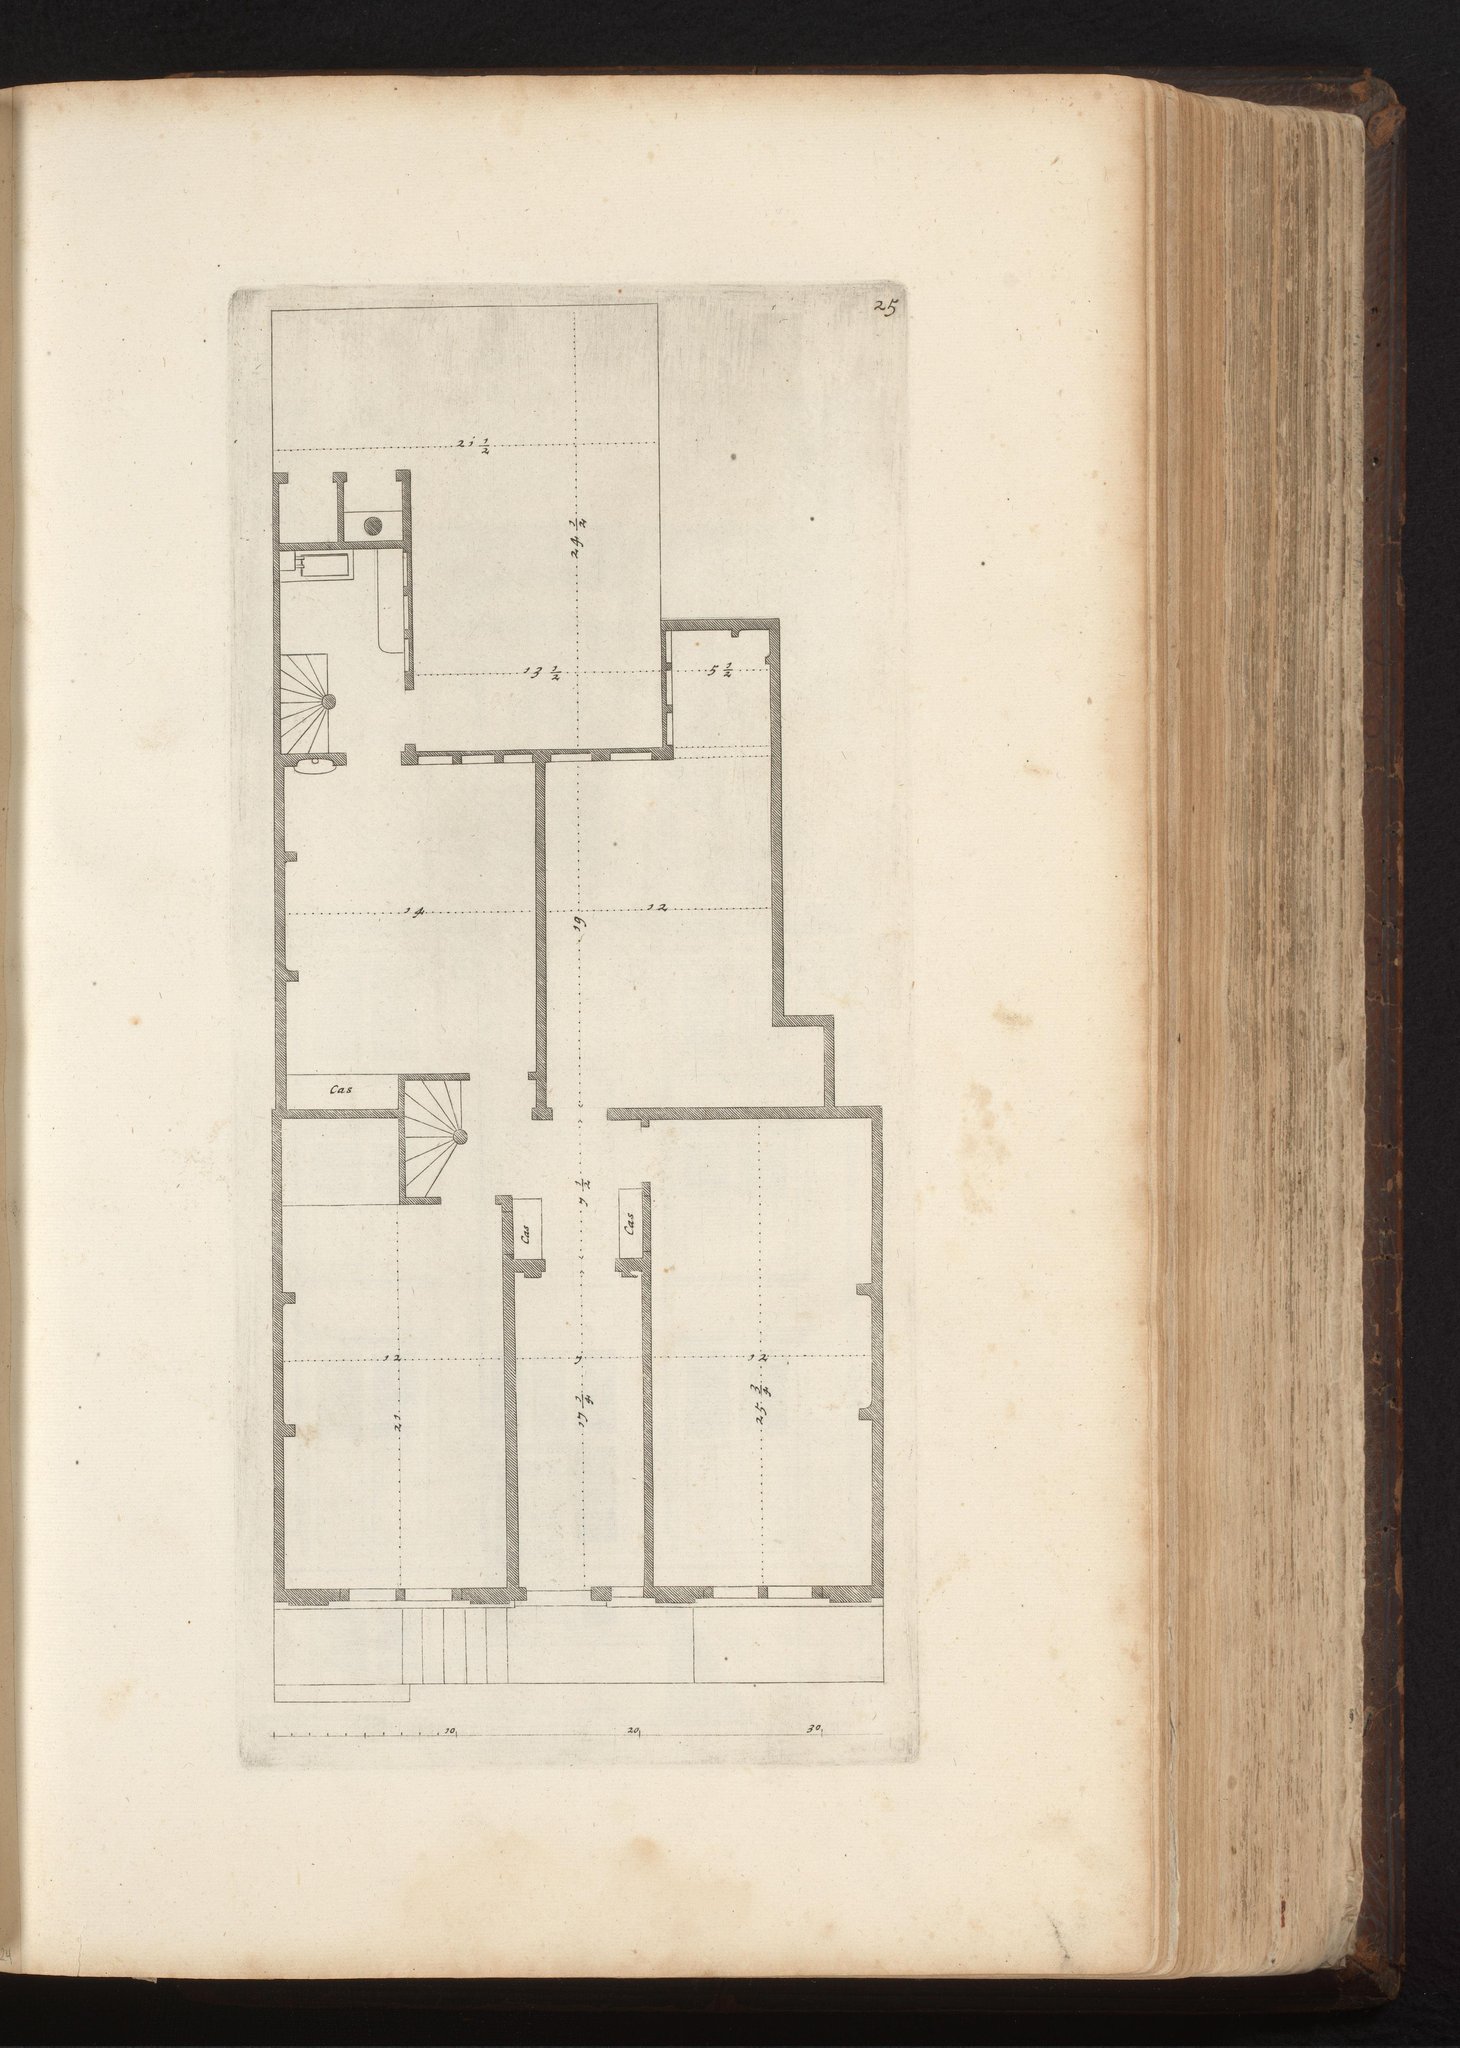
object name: print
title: Plattegrond van een herenhuis aan het Rokin te Amsterdam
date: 1648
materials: paper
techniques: engraving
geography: amsterdam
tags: plan ~ architecture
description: Prent uit: Afbeelsels der voornaemste gebouwen uyt alle die Philips Vingboons geordineert heeft. Amsterdam: Philips en Johannes Vinckboons en Johannes Willemszoon Blaeu, 1648.